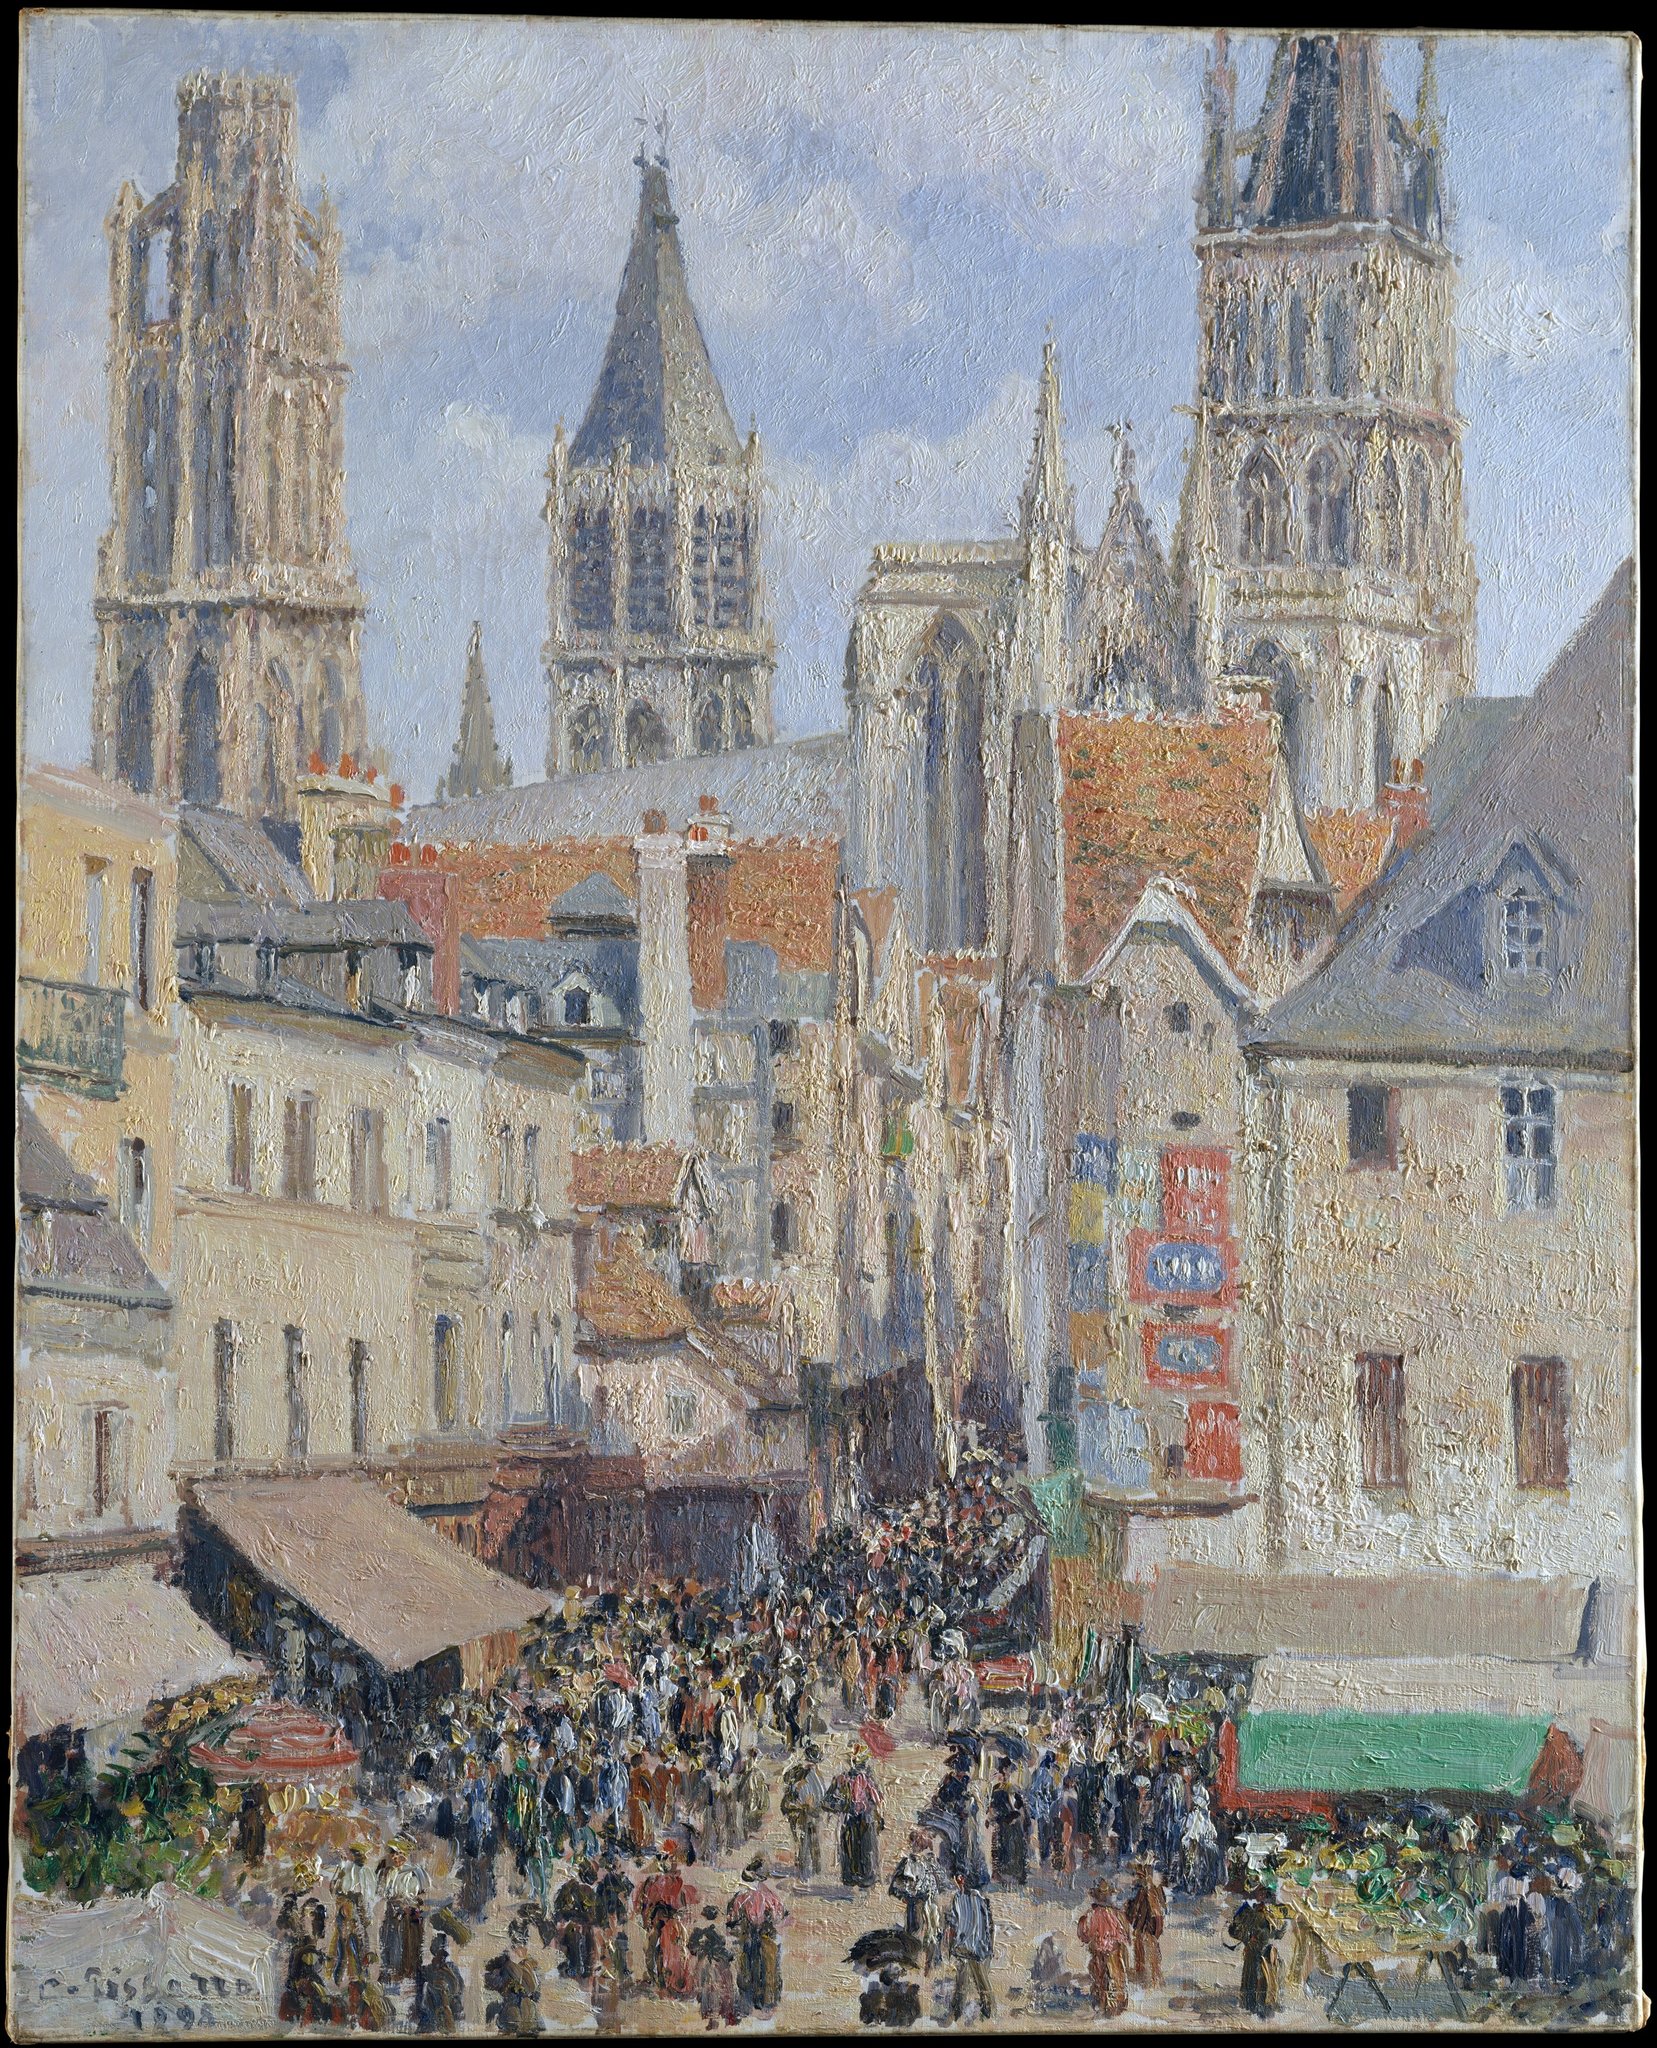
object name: painting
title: Rue de l'Epicerie, Rouen (Effect of Sunlight)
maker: camille pissarro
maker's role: artist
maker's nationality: french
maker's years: 1830-1903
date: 1898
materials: canvas, oil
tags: cathedrals,towns,markets